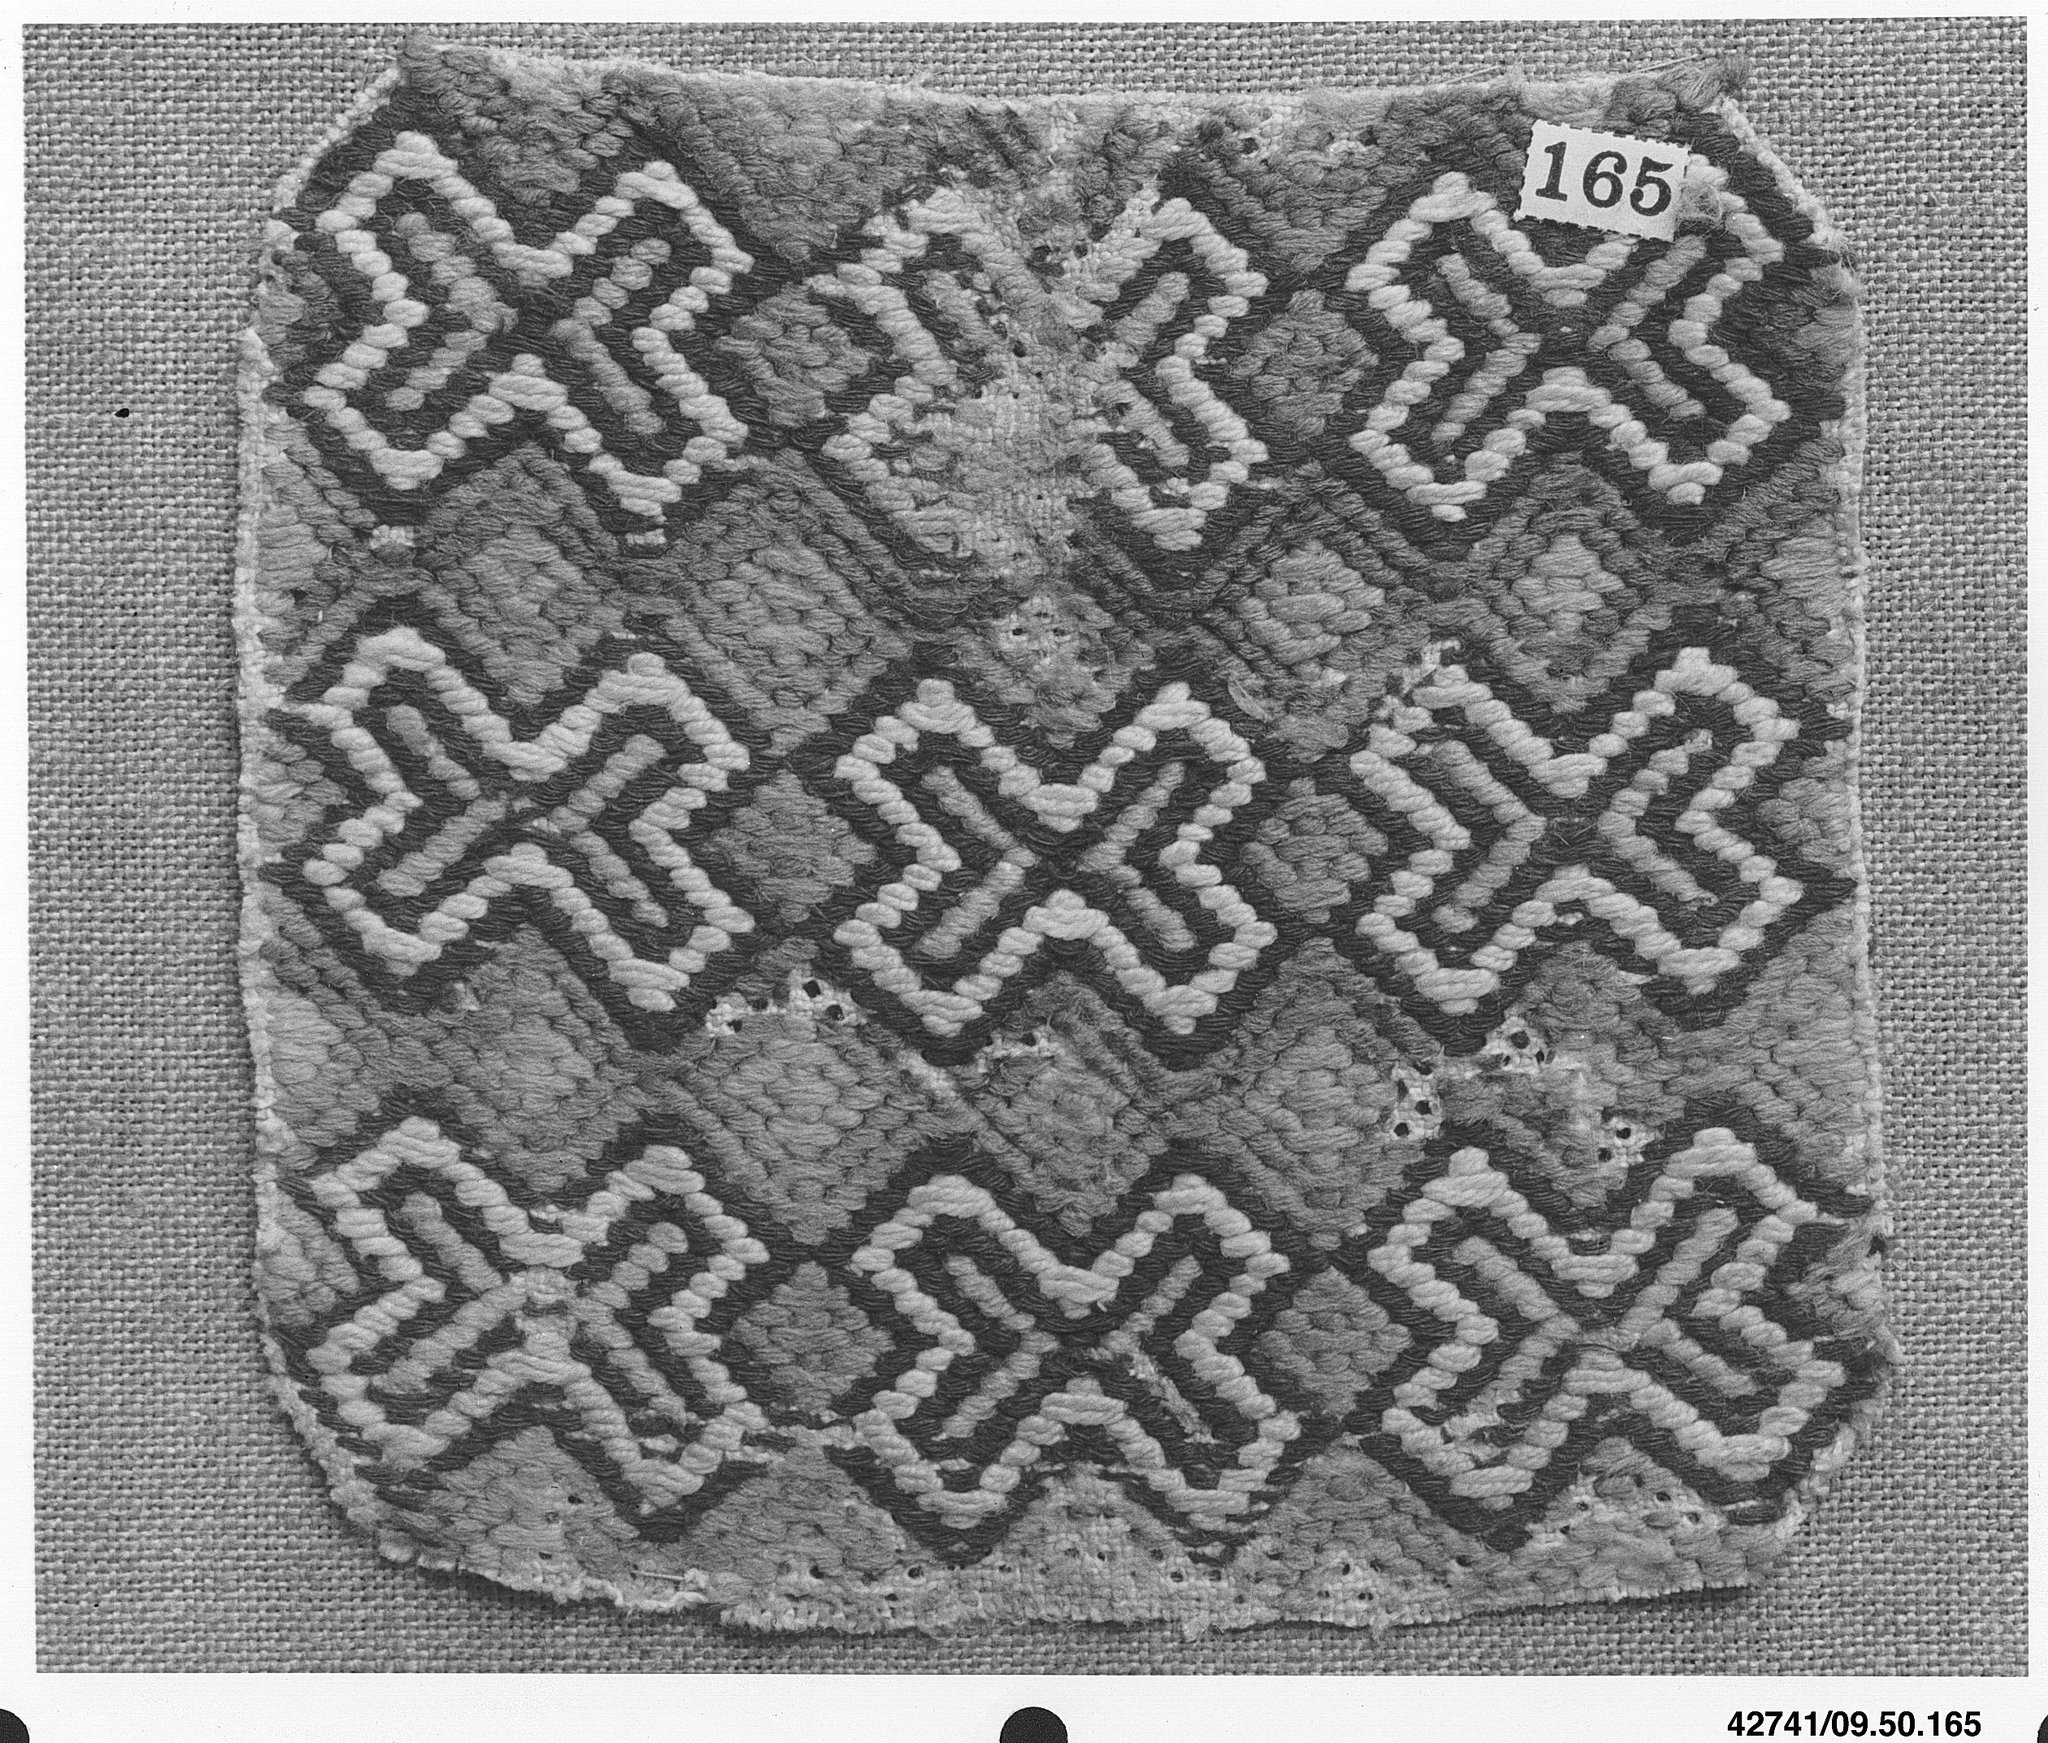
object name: costume fragment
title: Peasant costume fragment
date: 1701-1900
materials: canvas, wool